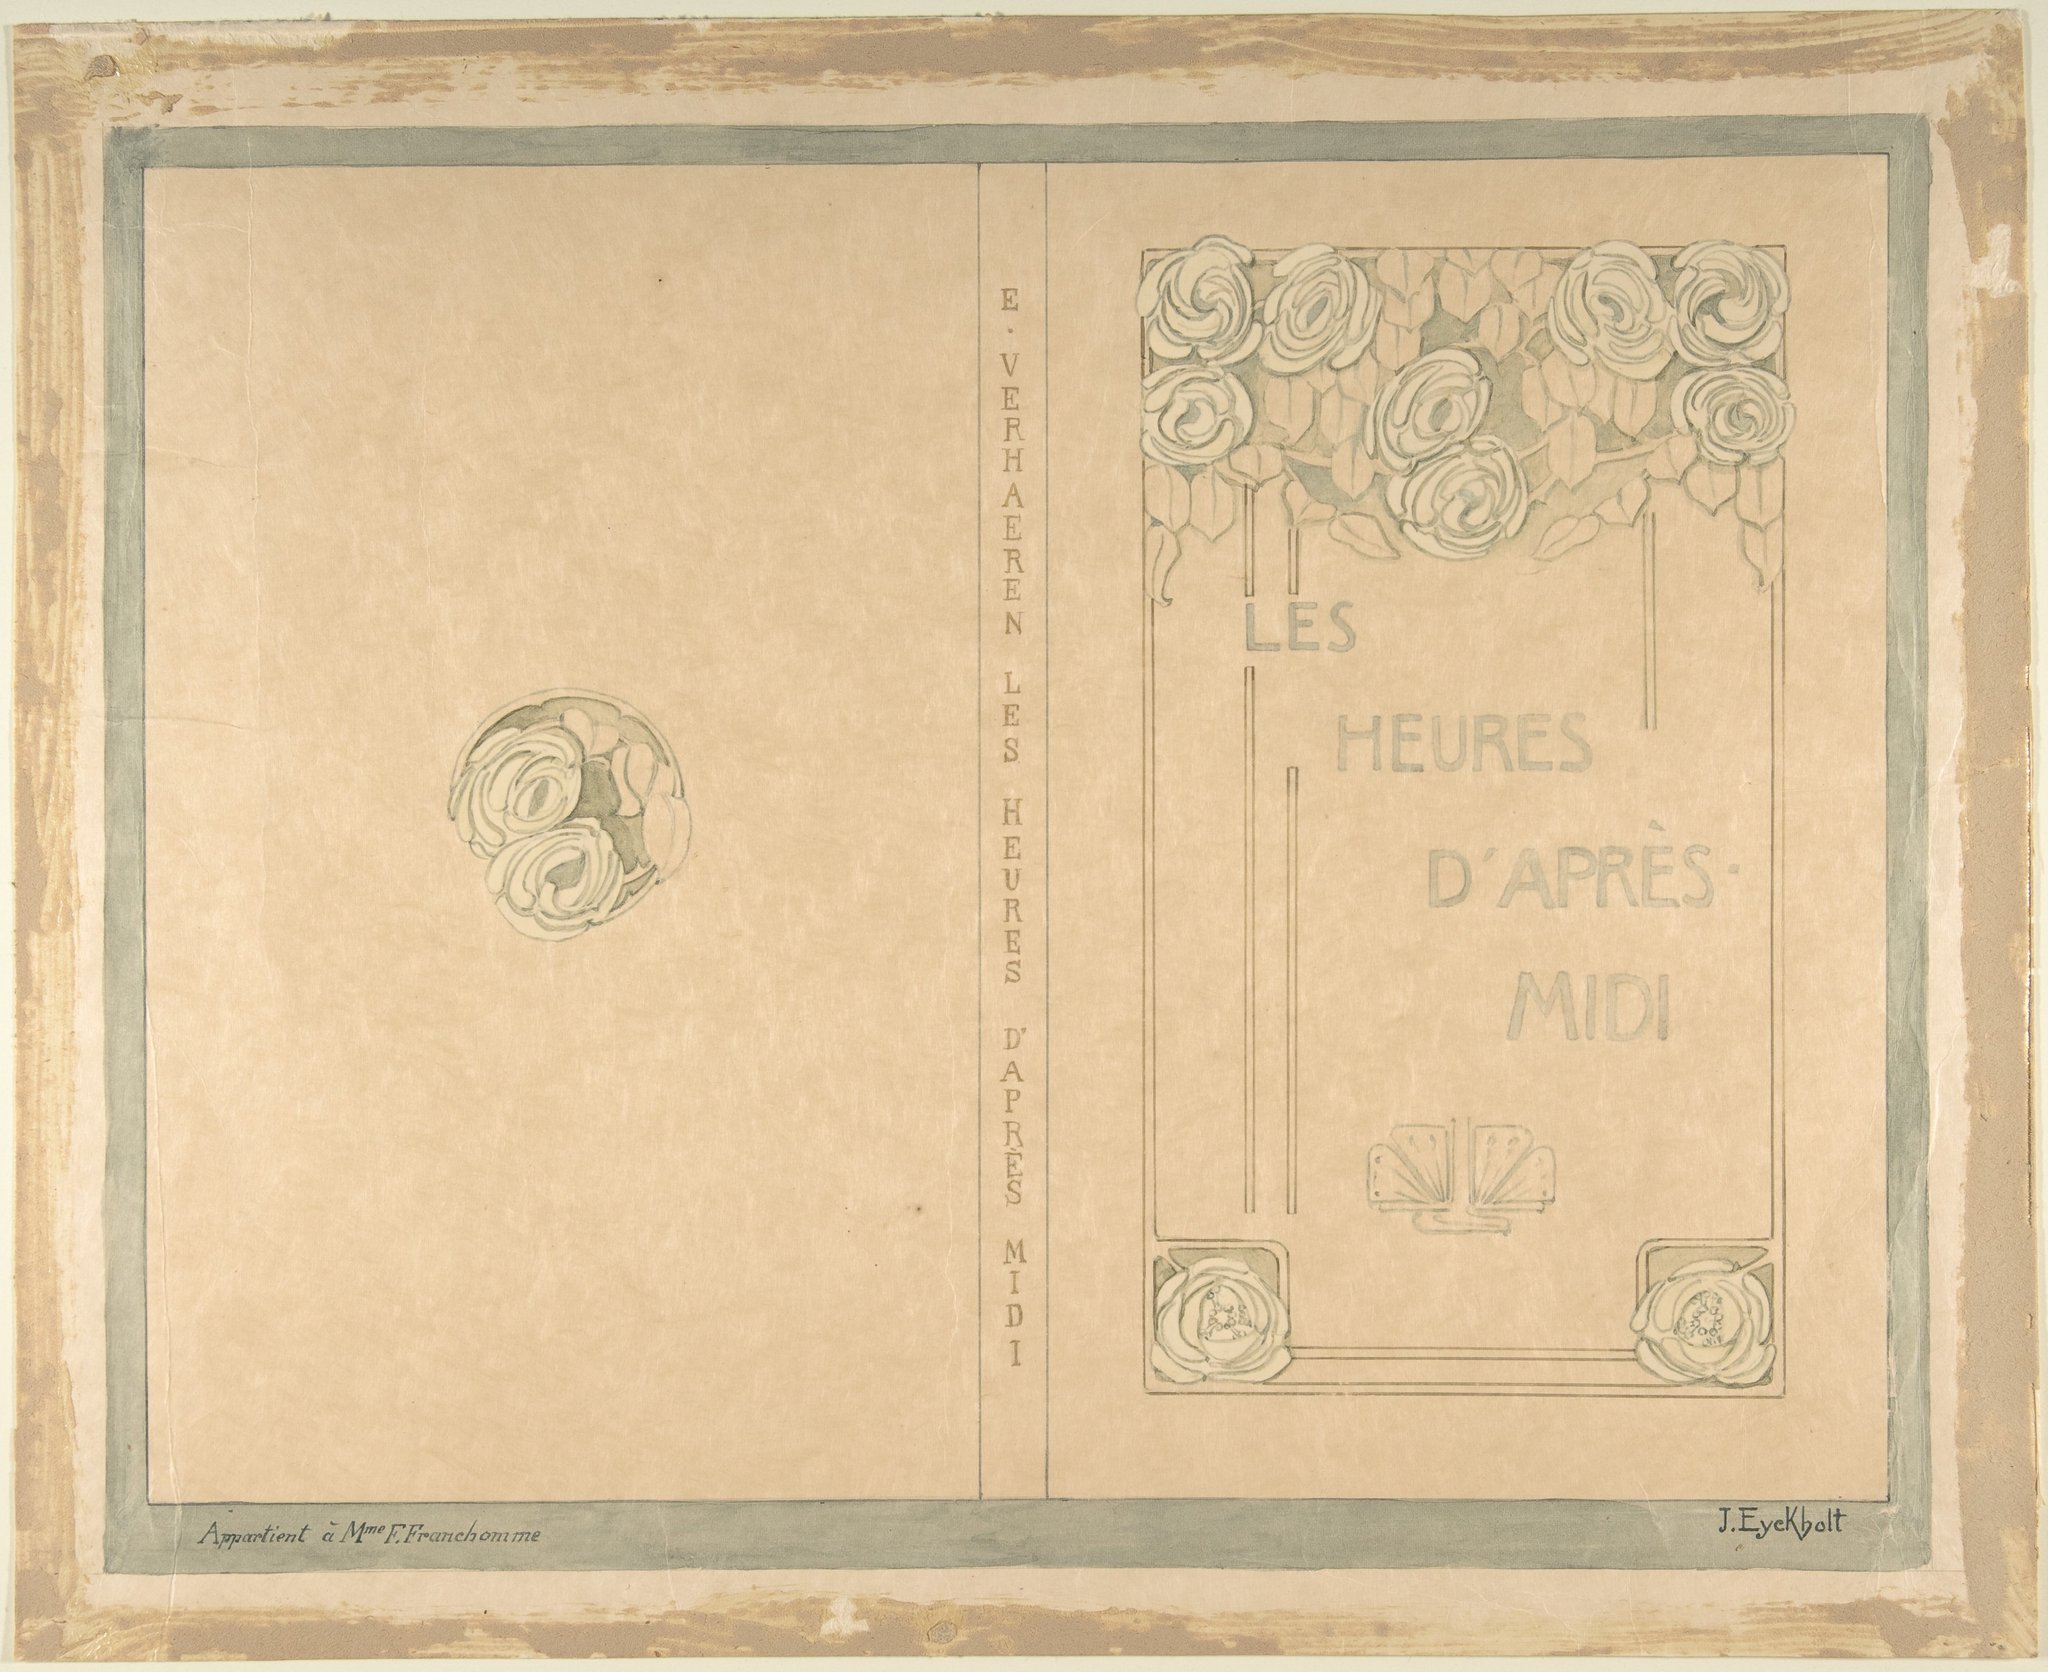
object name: drawing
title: Design for "Les Heures d'Après Midi" by Emile Verhaeren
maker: julia eyckholt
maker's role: artist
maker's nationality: belgian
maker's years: 1902-1914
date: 1896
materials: gold, graphite, ink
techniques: brush, pen, drawing, wash